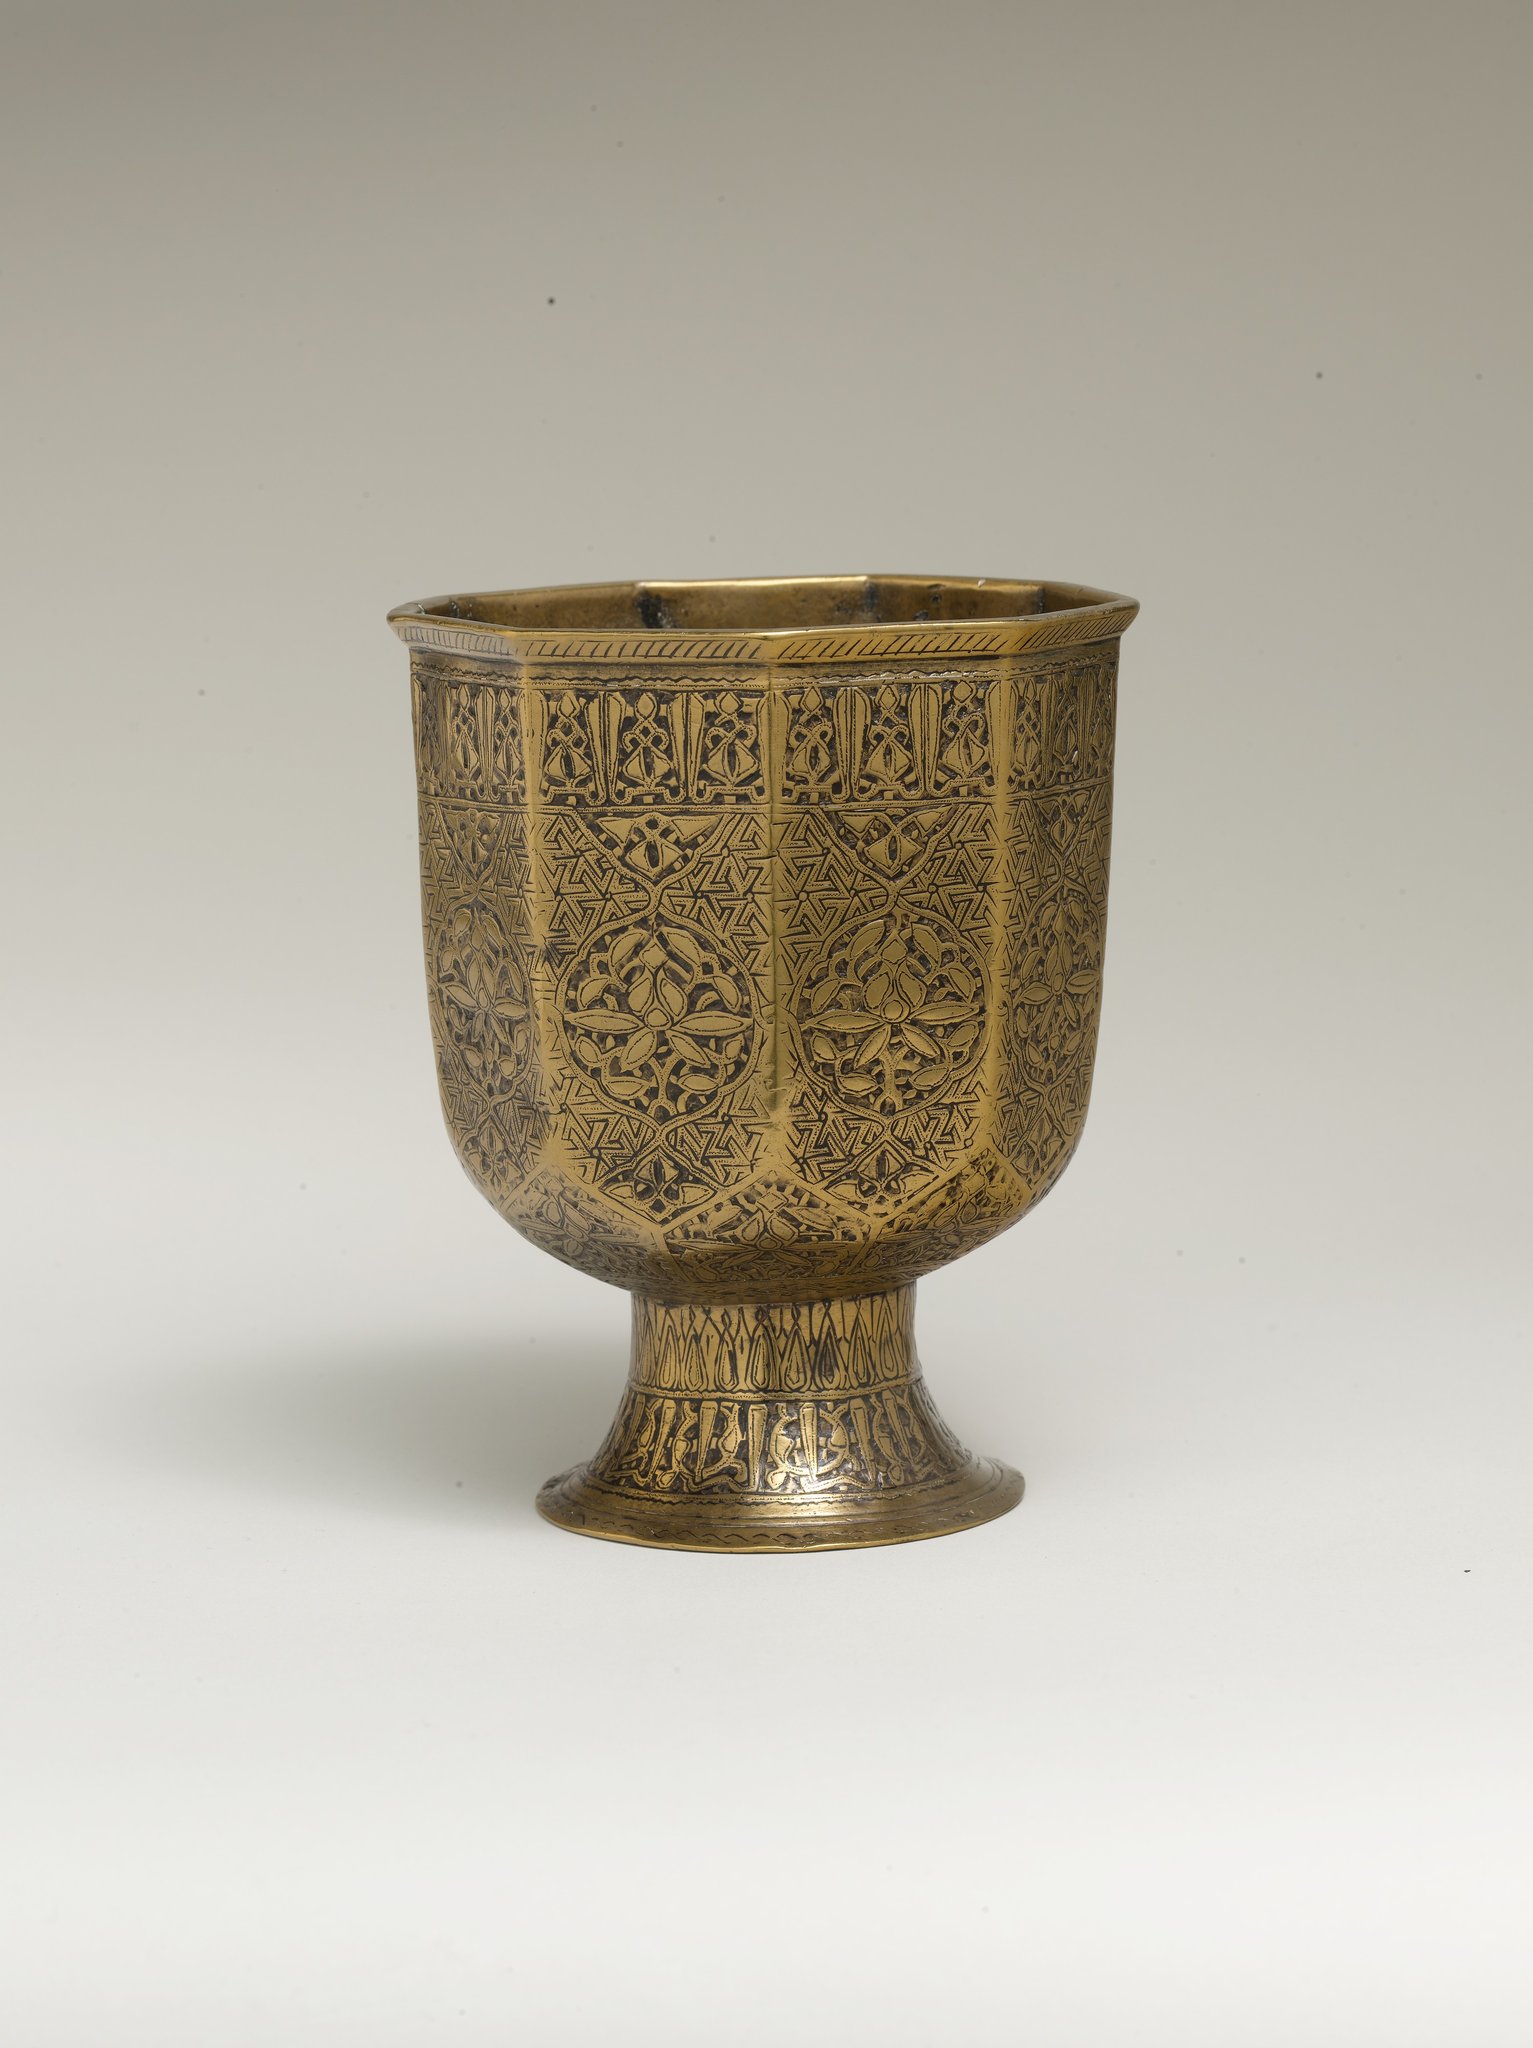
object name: cup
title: Footed Cup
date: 1351-1400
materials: brass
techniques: casting, engraving, inlay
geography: iran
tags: arabic